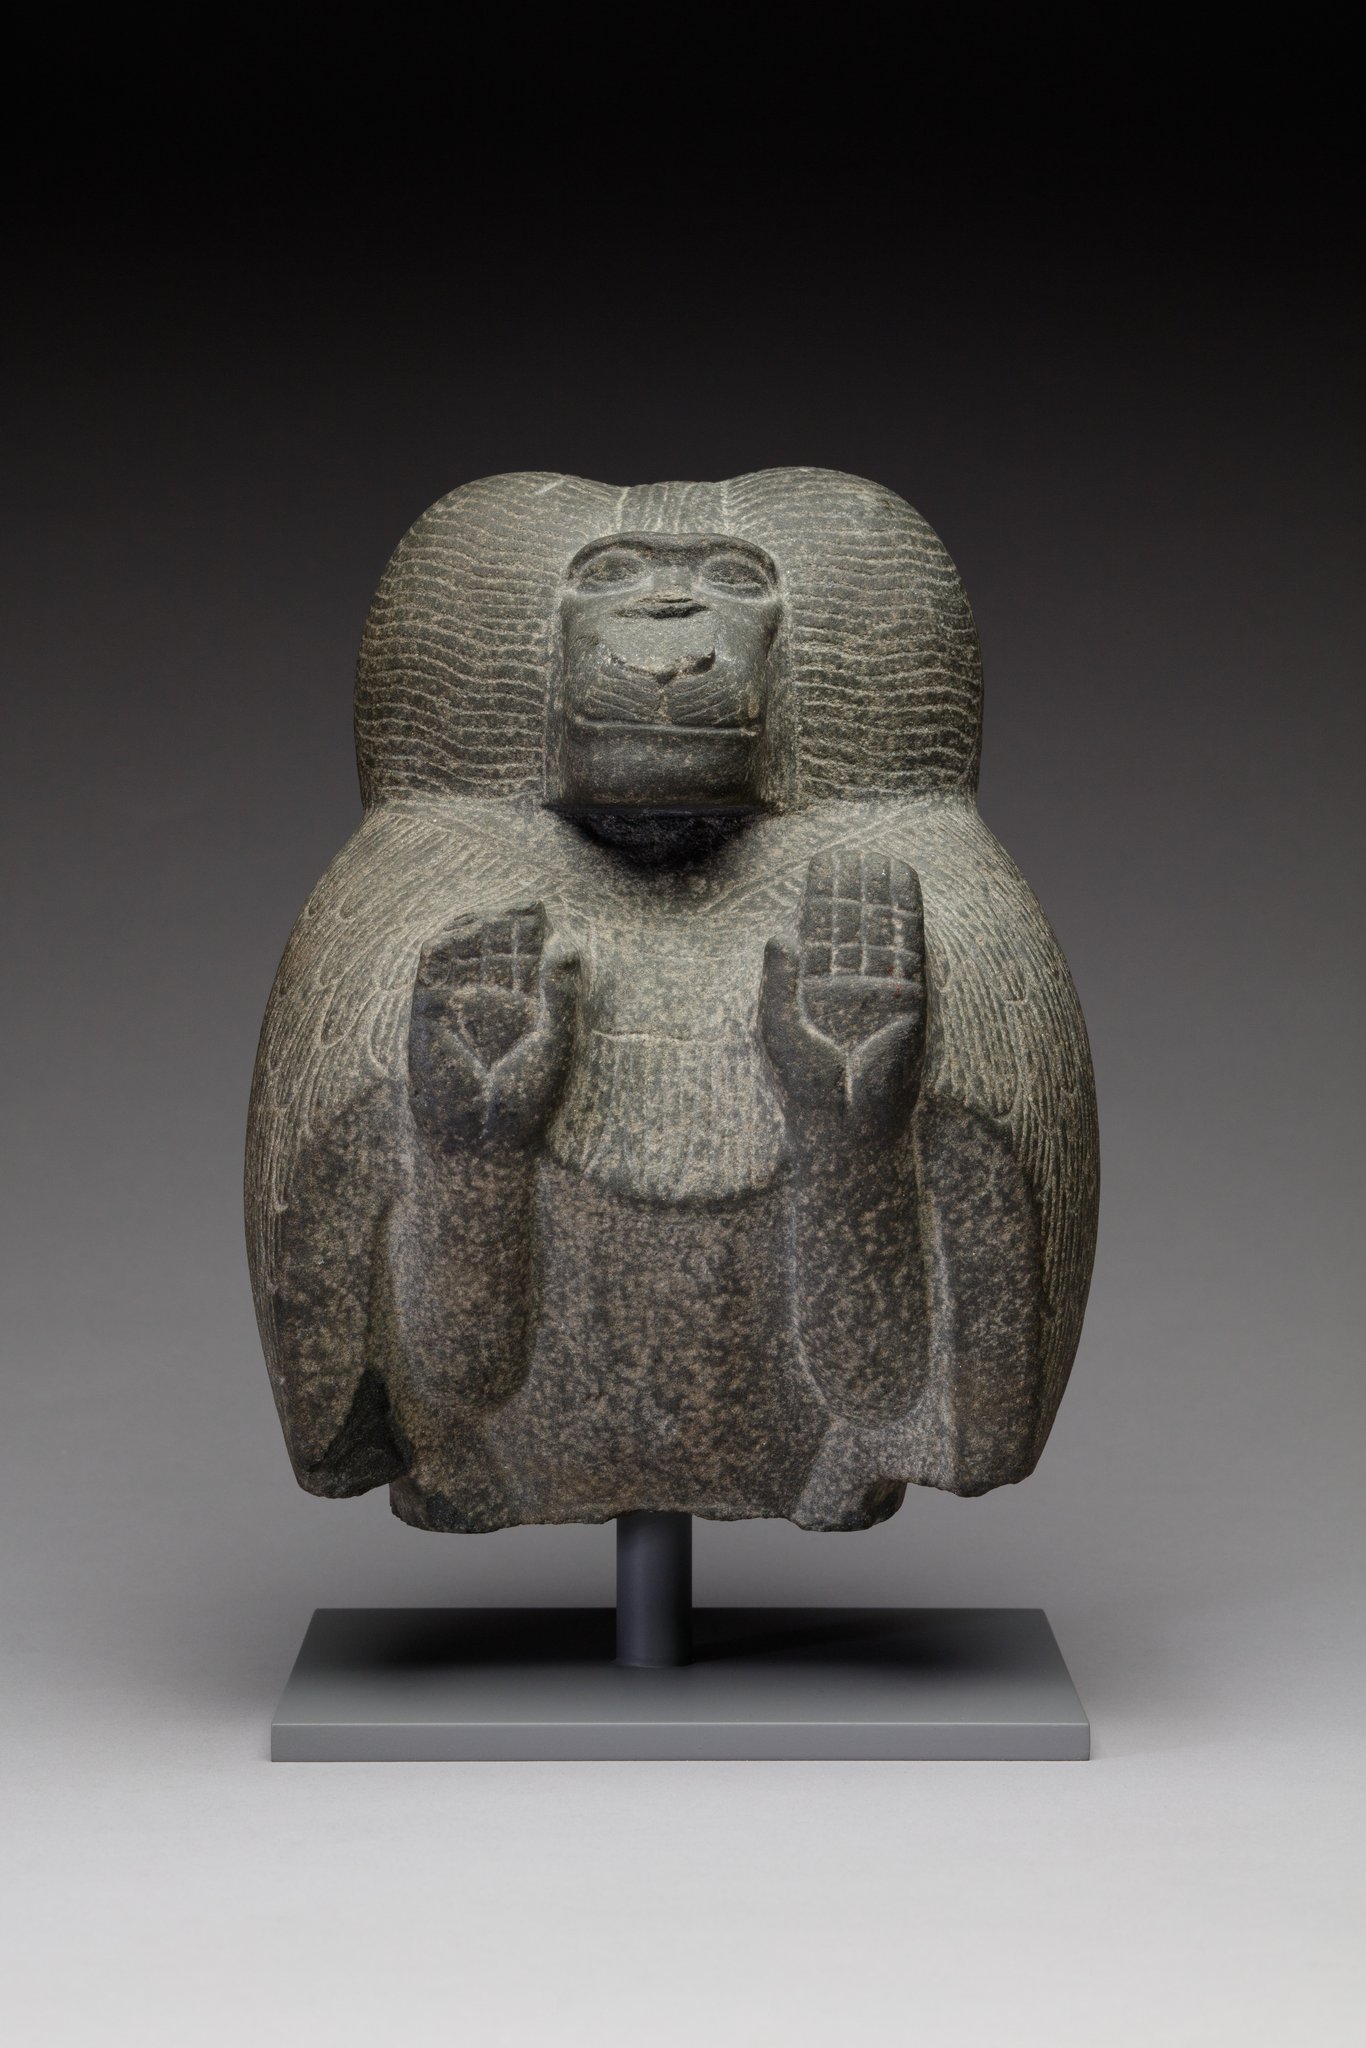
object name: statuette, baboon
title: Statuette depicting a worshipping baboon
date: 1279-1213 BCE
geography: egypt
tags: baboons